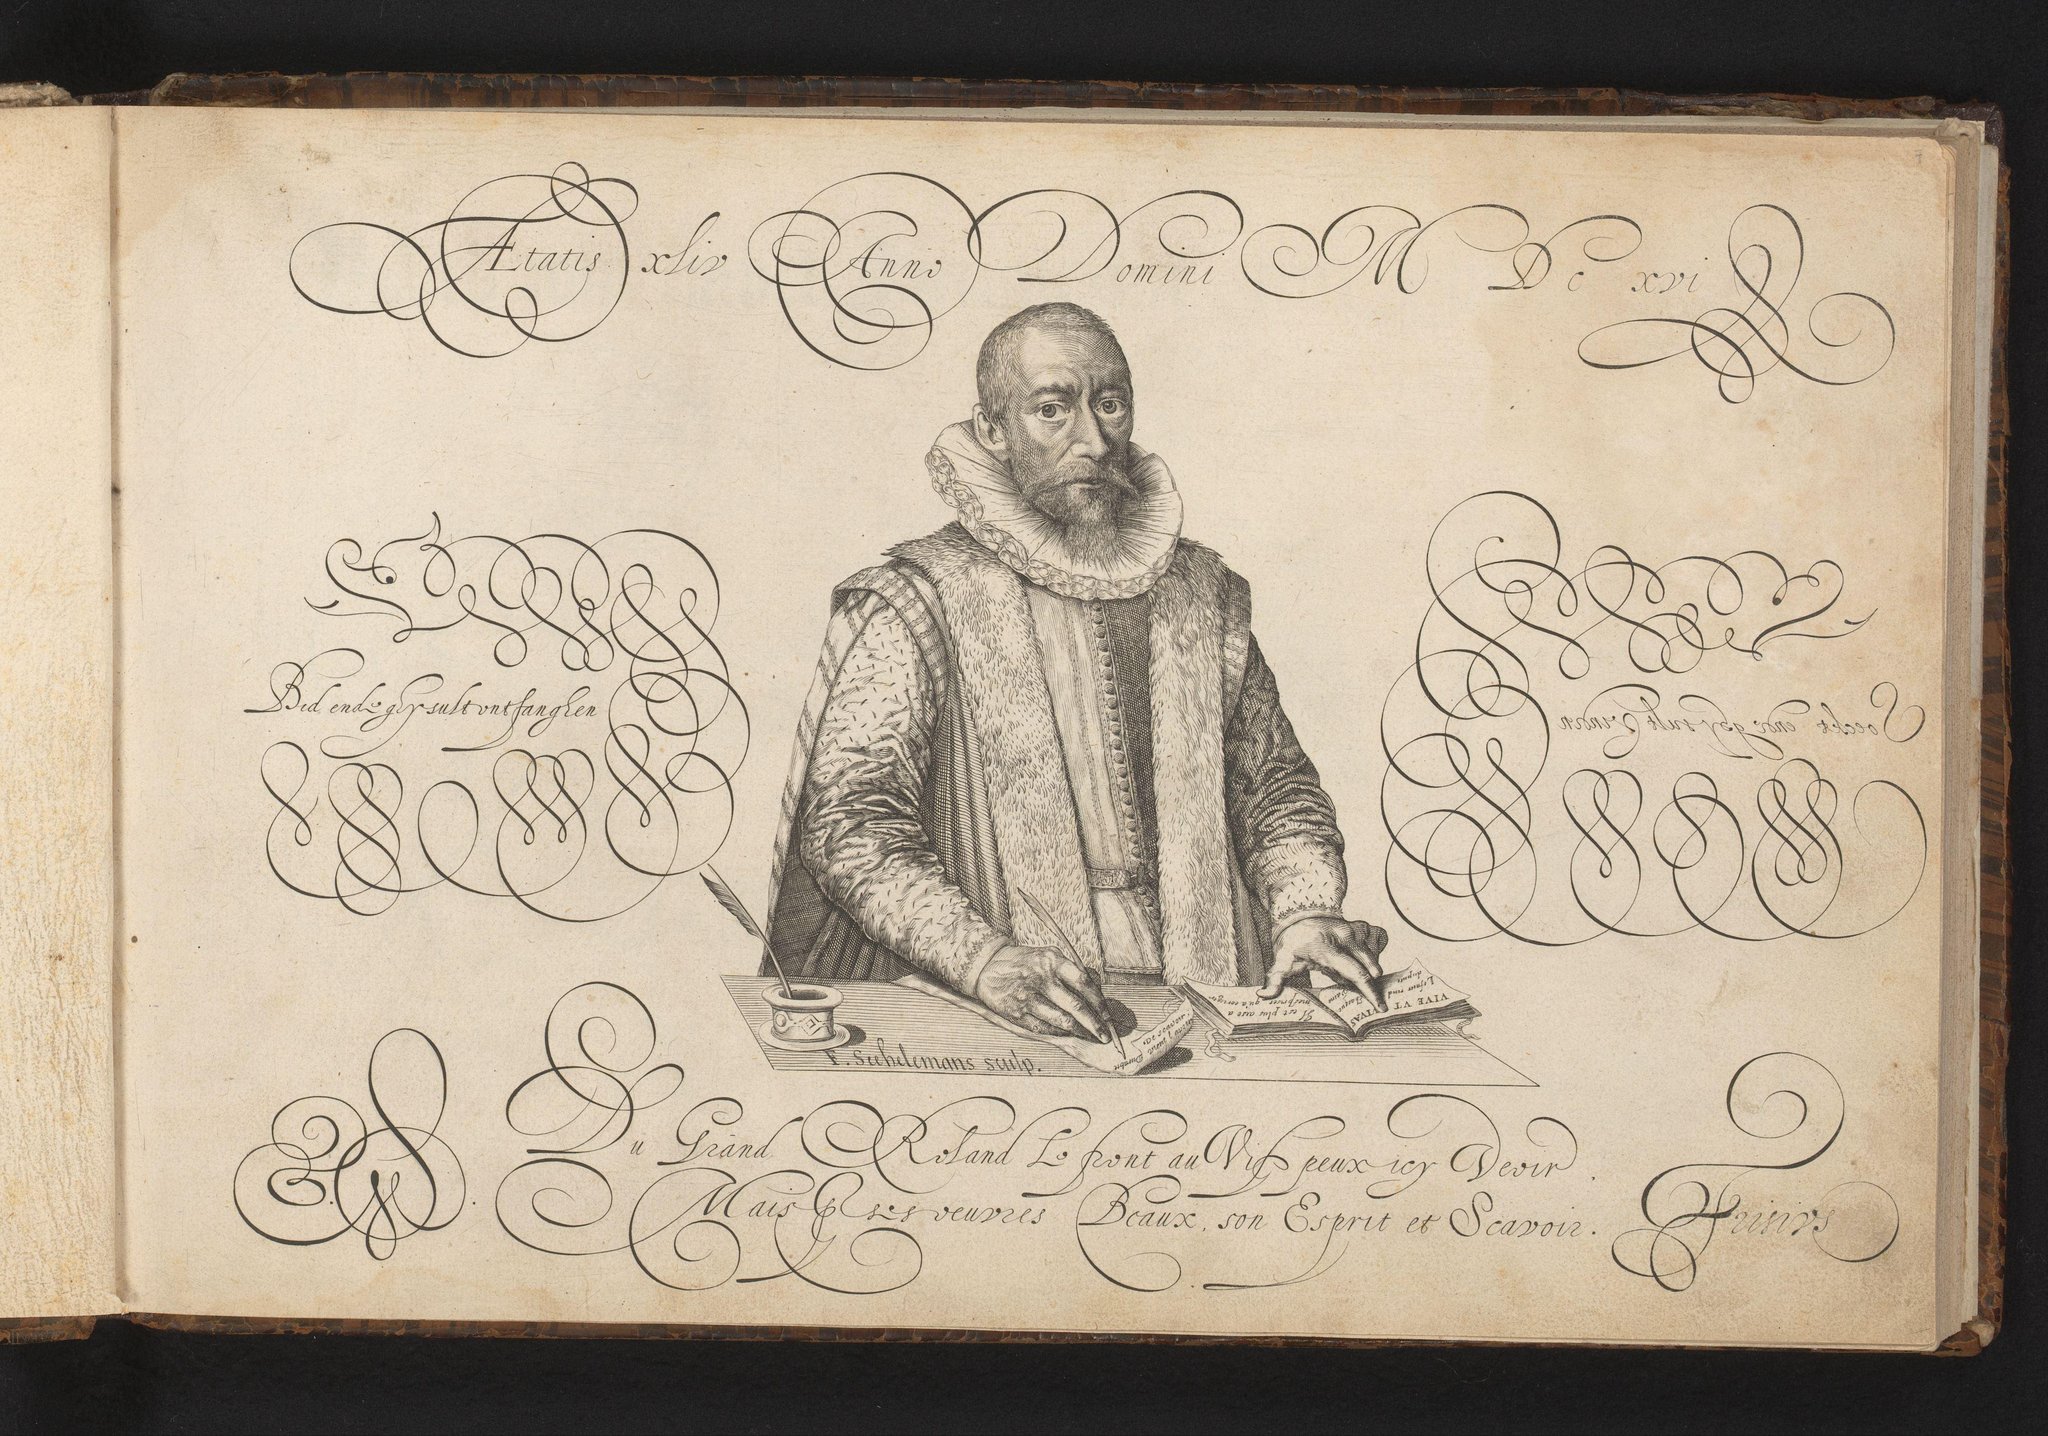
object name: album leaf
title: 't Magazin oft pac-huys der loffelycker penn-const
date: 1616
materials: paper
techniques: engraving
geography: middelburg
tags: antwerp, david roelands, calligraphy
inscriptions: date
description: Portret van David Roelands, schoolmeester en kalligraaf te Vlissingen, schrijvend. Links van het portret staat in kalligrafie: Bid en ghy sult ontfanghen. Rechts staat omgekeerd: Soeckt en ghy sult vinden. De prent maakt deel uit van een album.